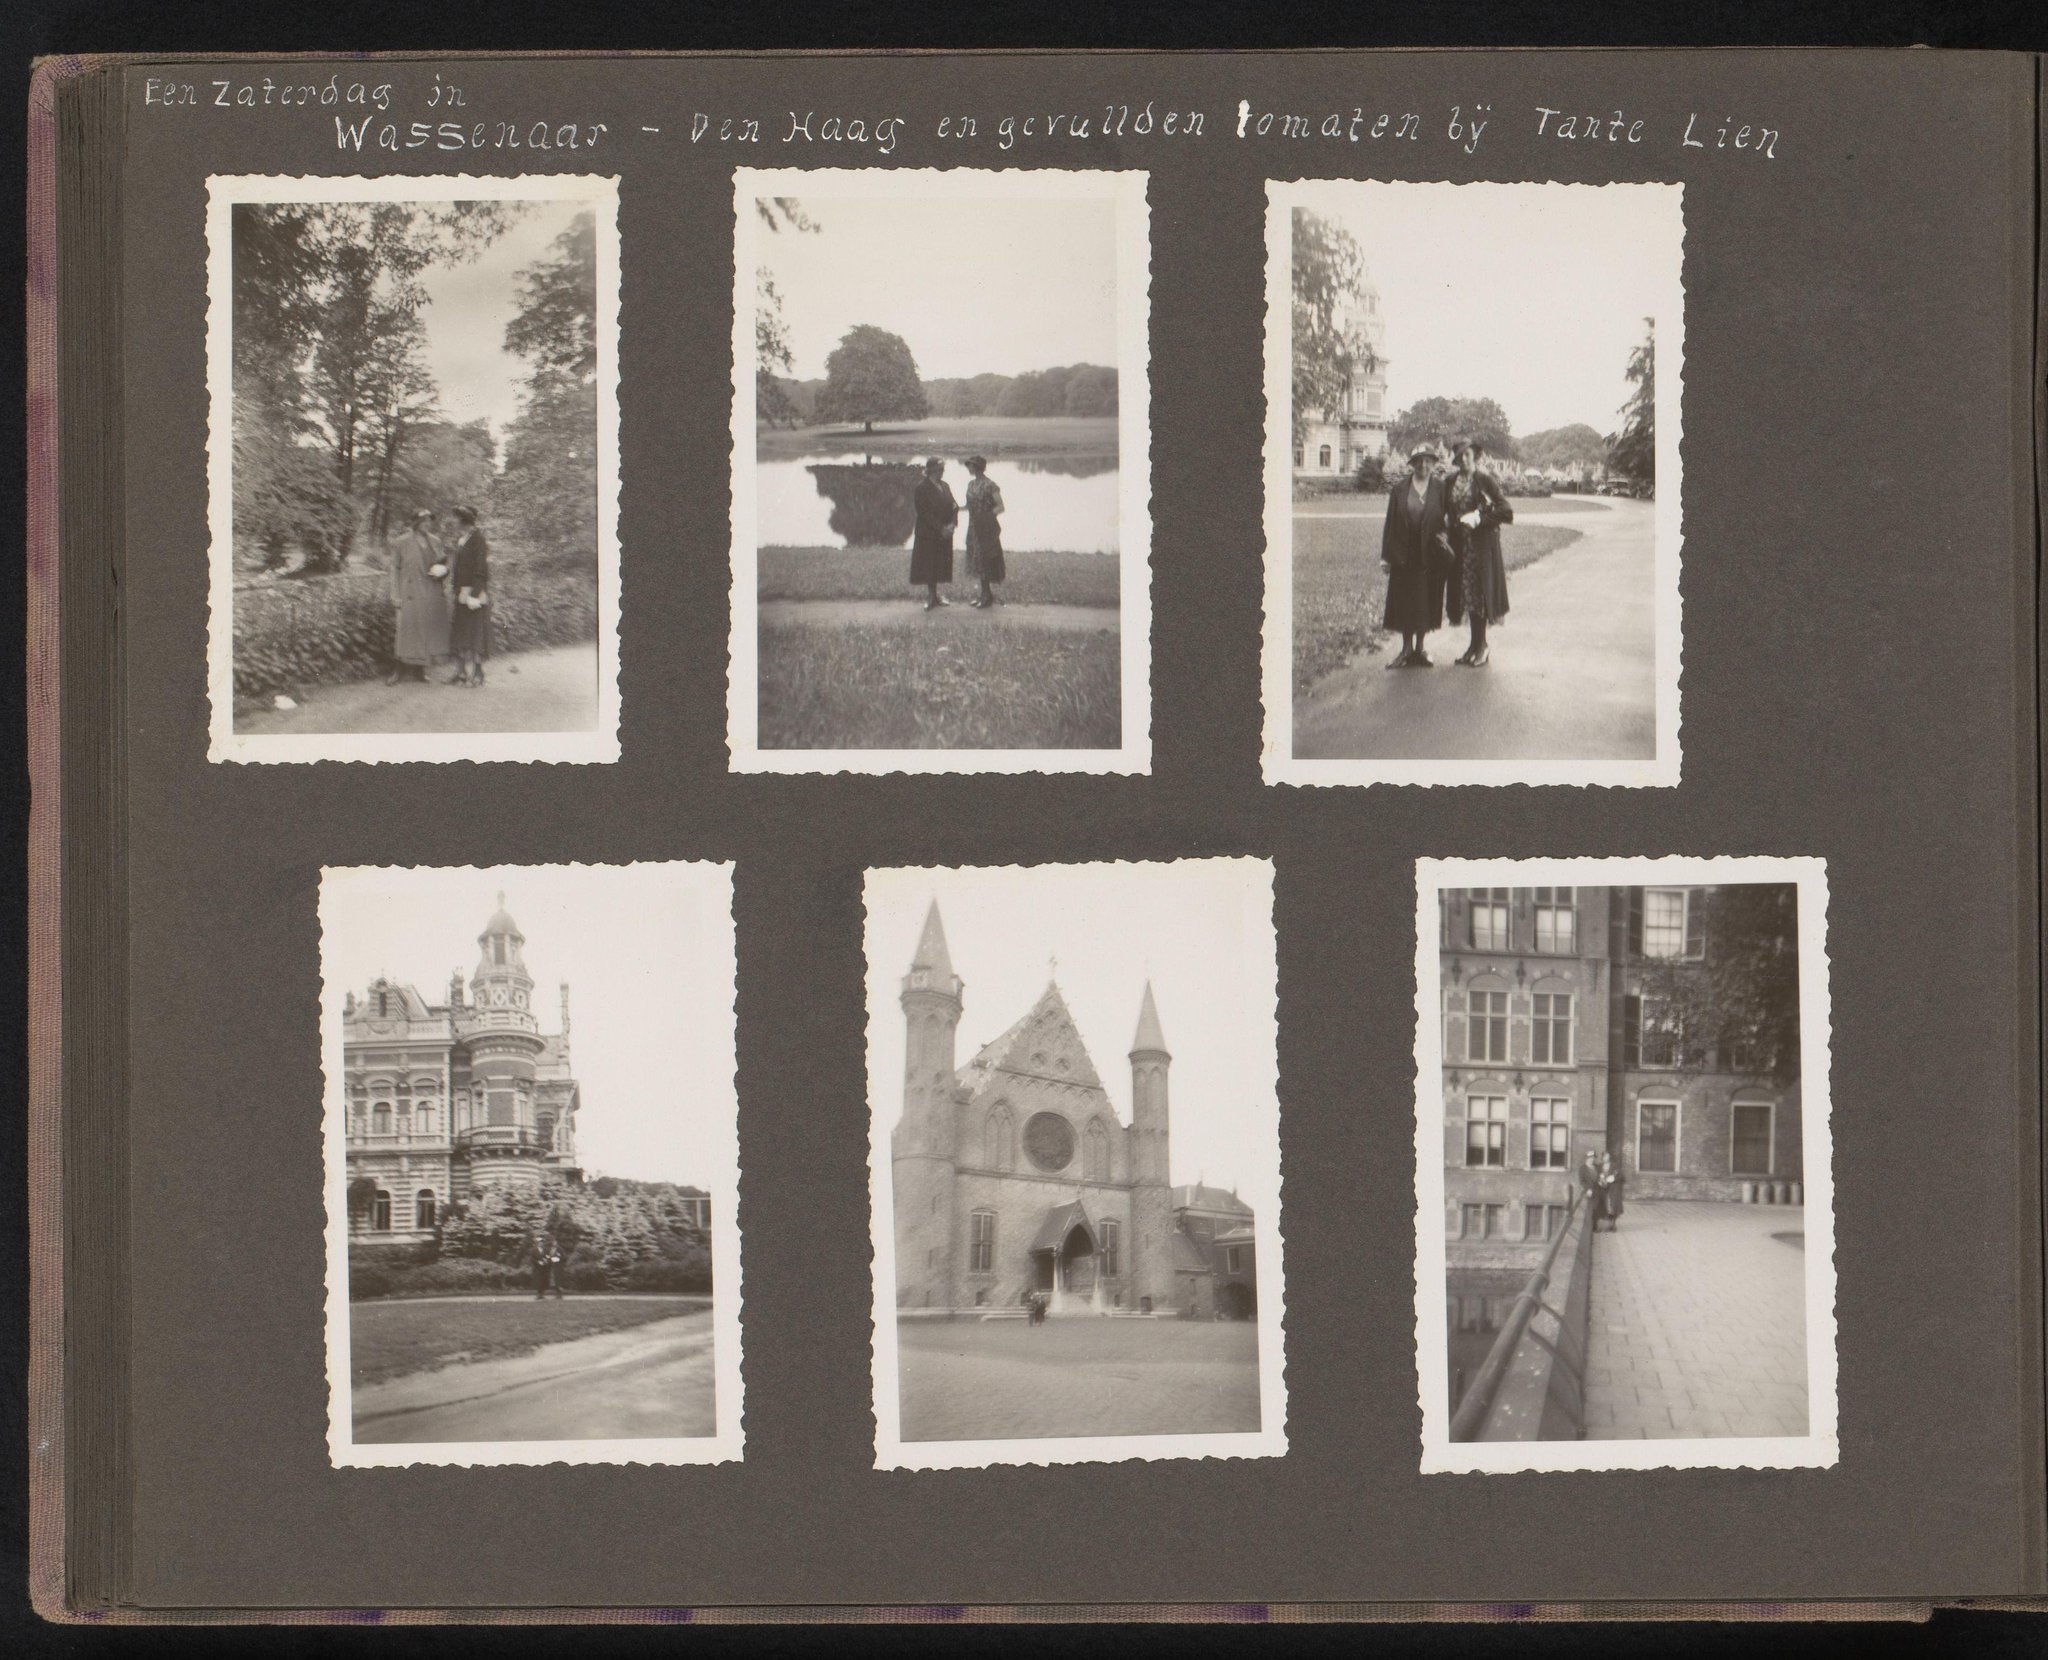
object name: photograph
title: Berti Hoppe en haar tante bij Kasteel Oud-Wassenaar en het Binnenhof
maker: herman besselaar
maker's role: taalkundige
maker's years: 1904-1994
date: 1933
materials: cardboard, paper, photographic support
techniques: gelatin silver print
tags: castle, lower house, parliament, chamber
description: Zes foto's gemaakt tijdens het bezoek van Berti Hoppe en Herman Besselaar aan Wassenaar en Den Haag. Deze pagina maakt deel uit van een album.